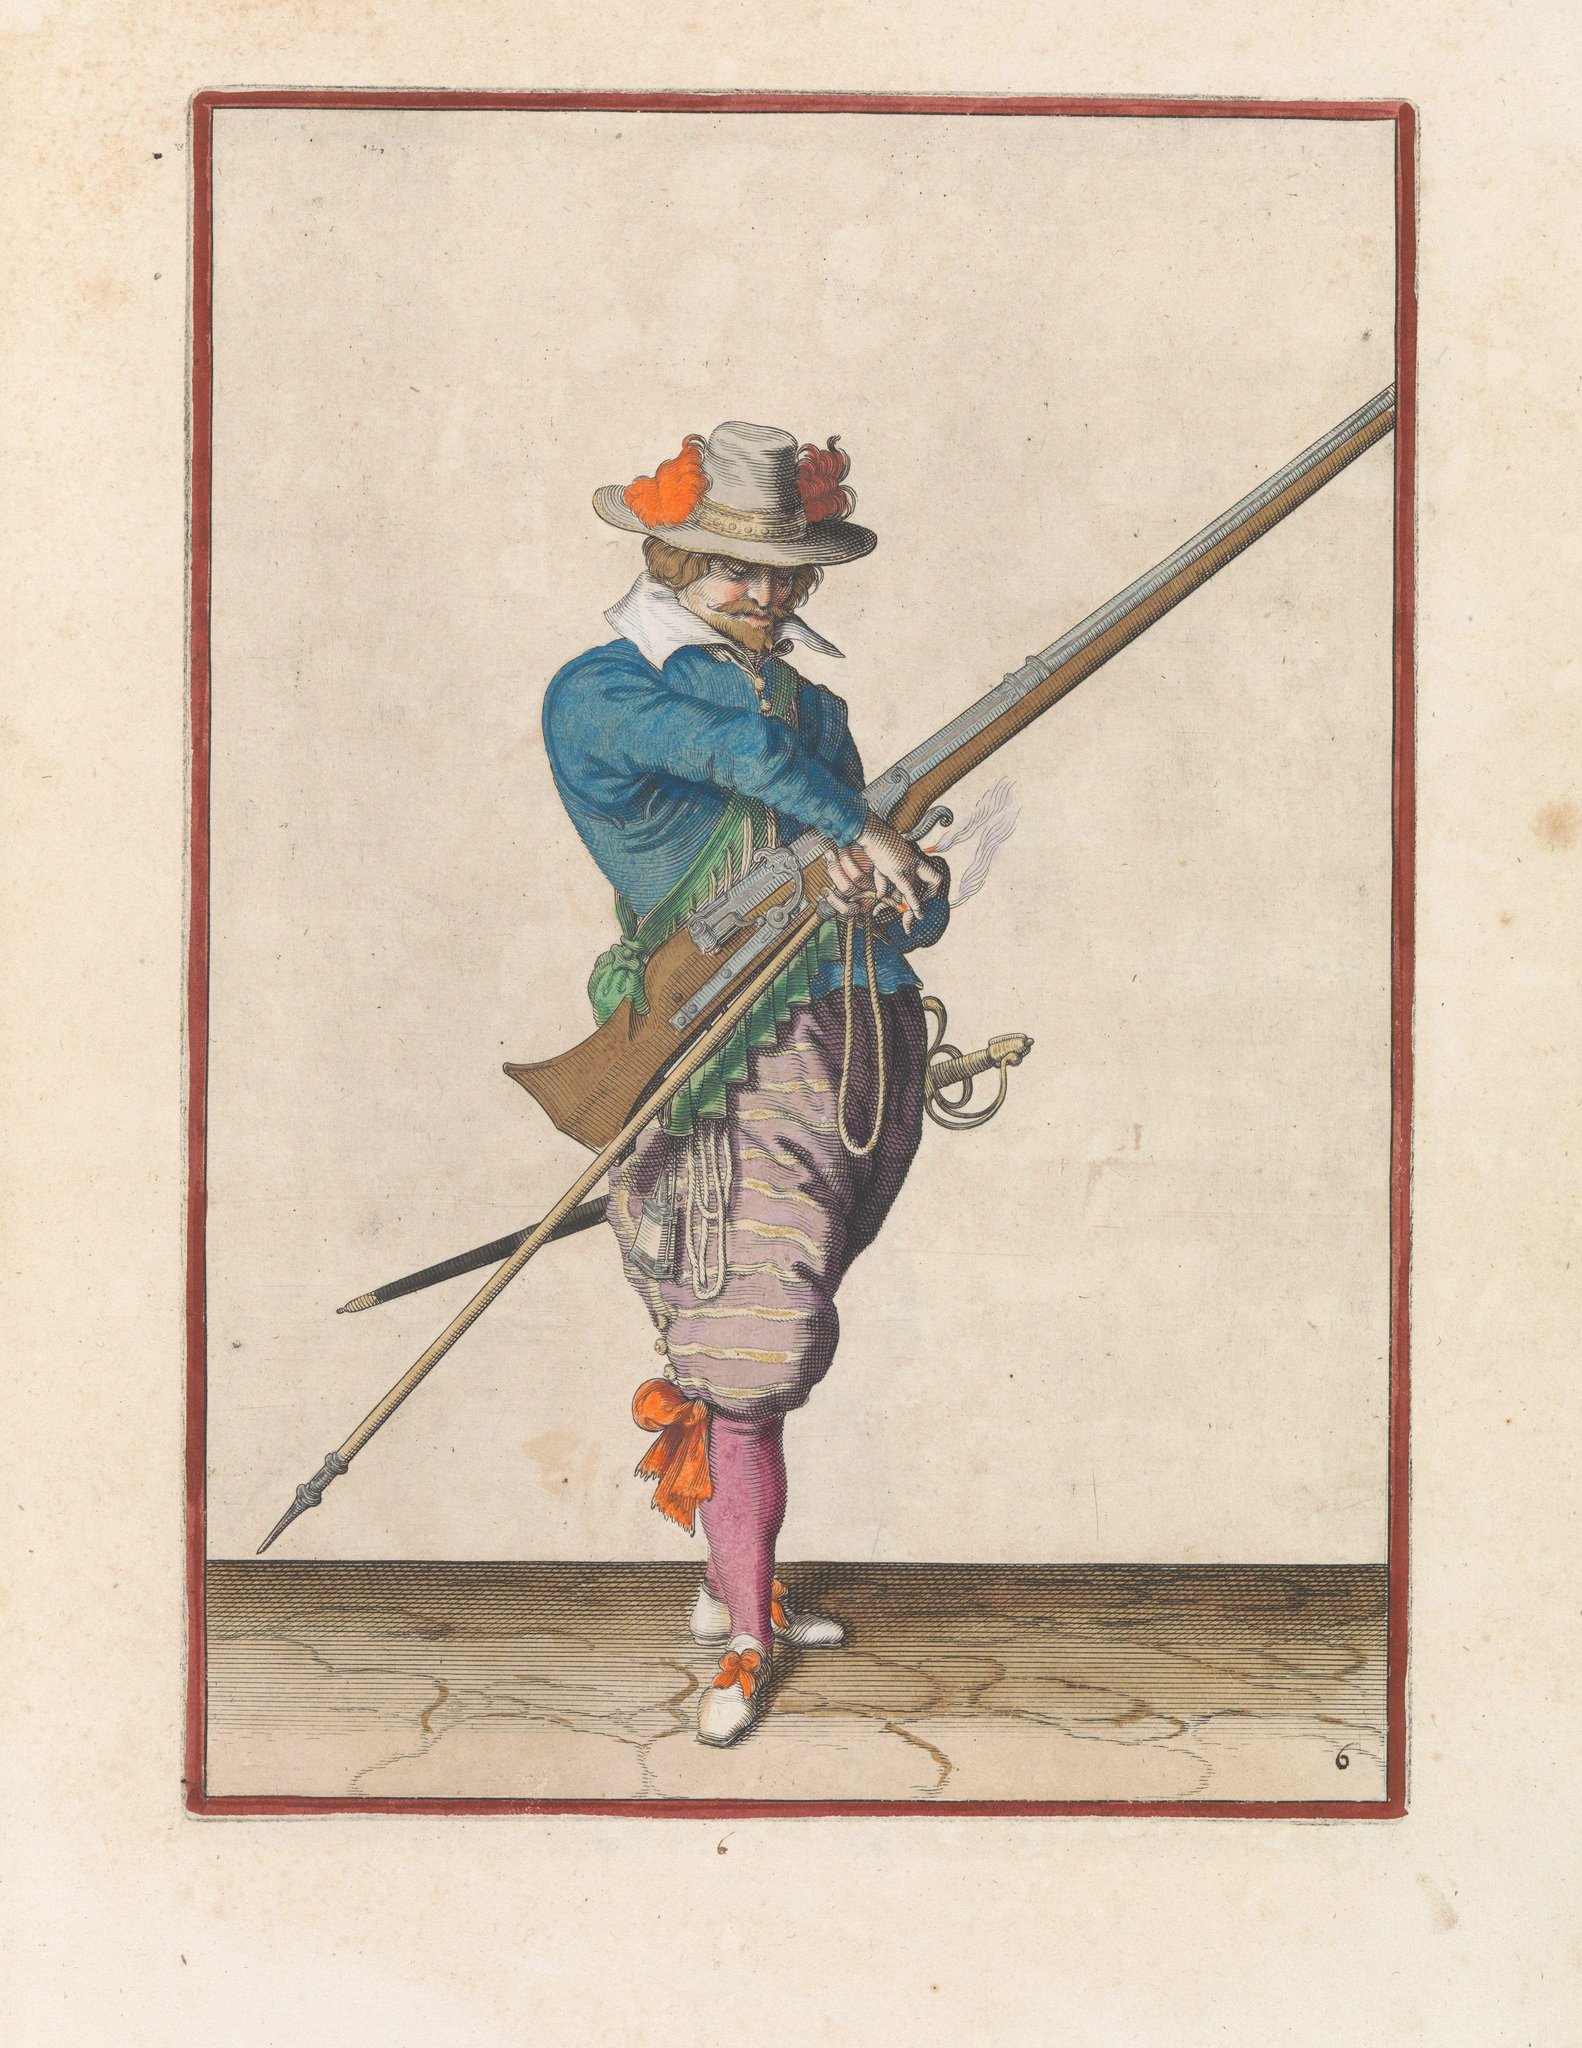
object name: print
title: Corte onderrechtinghe op de figuerliicke afbeeldinghe, soo veel aengaet het recht ghebruyck vant Musquet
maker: jacques de gheyn (ii)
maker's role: painter, print maker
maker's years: 1565-1629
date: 1597-1607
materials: paper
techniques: engraving, hand coloring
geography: the hague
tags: handling of weapons ~ military training, firearms: rifle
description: Een soldaat, ten voeten uit, naar rechts, die een musket (een bepaald type vuurwapen) met zijn linkerhand vasthoudt. In zijn linkerhand behalve het musket ook een furket (musketvork) en een brandende lont. Met zijn rechterhand pakt hij deze lont. Deze prent is onderdeel van de reeks van 43 met de hand genummerde prenten van musketiers in de Wapenhandelinghe.